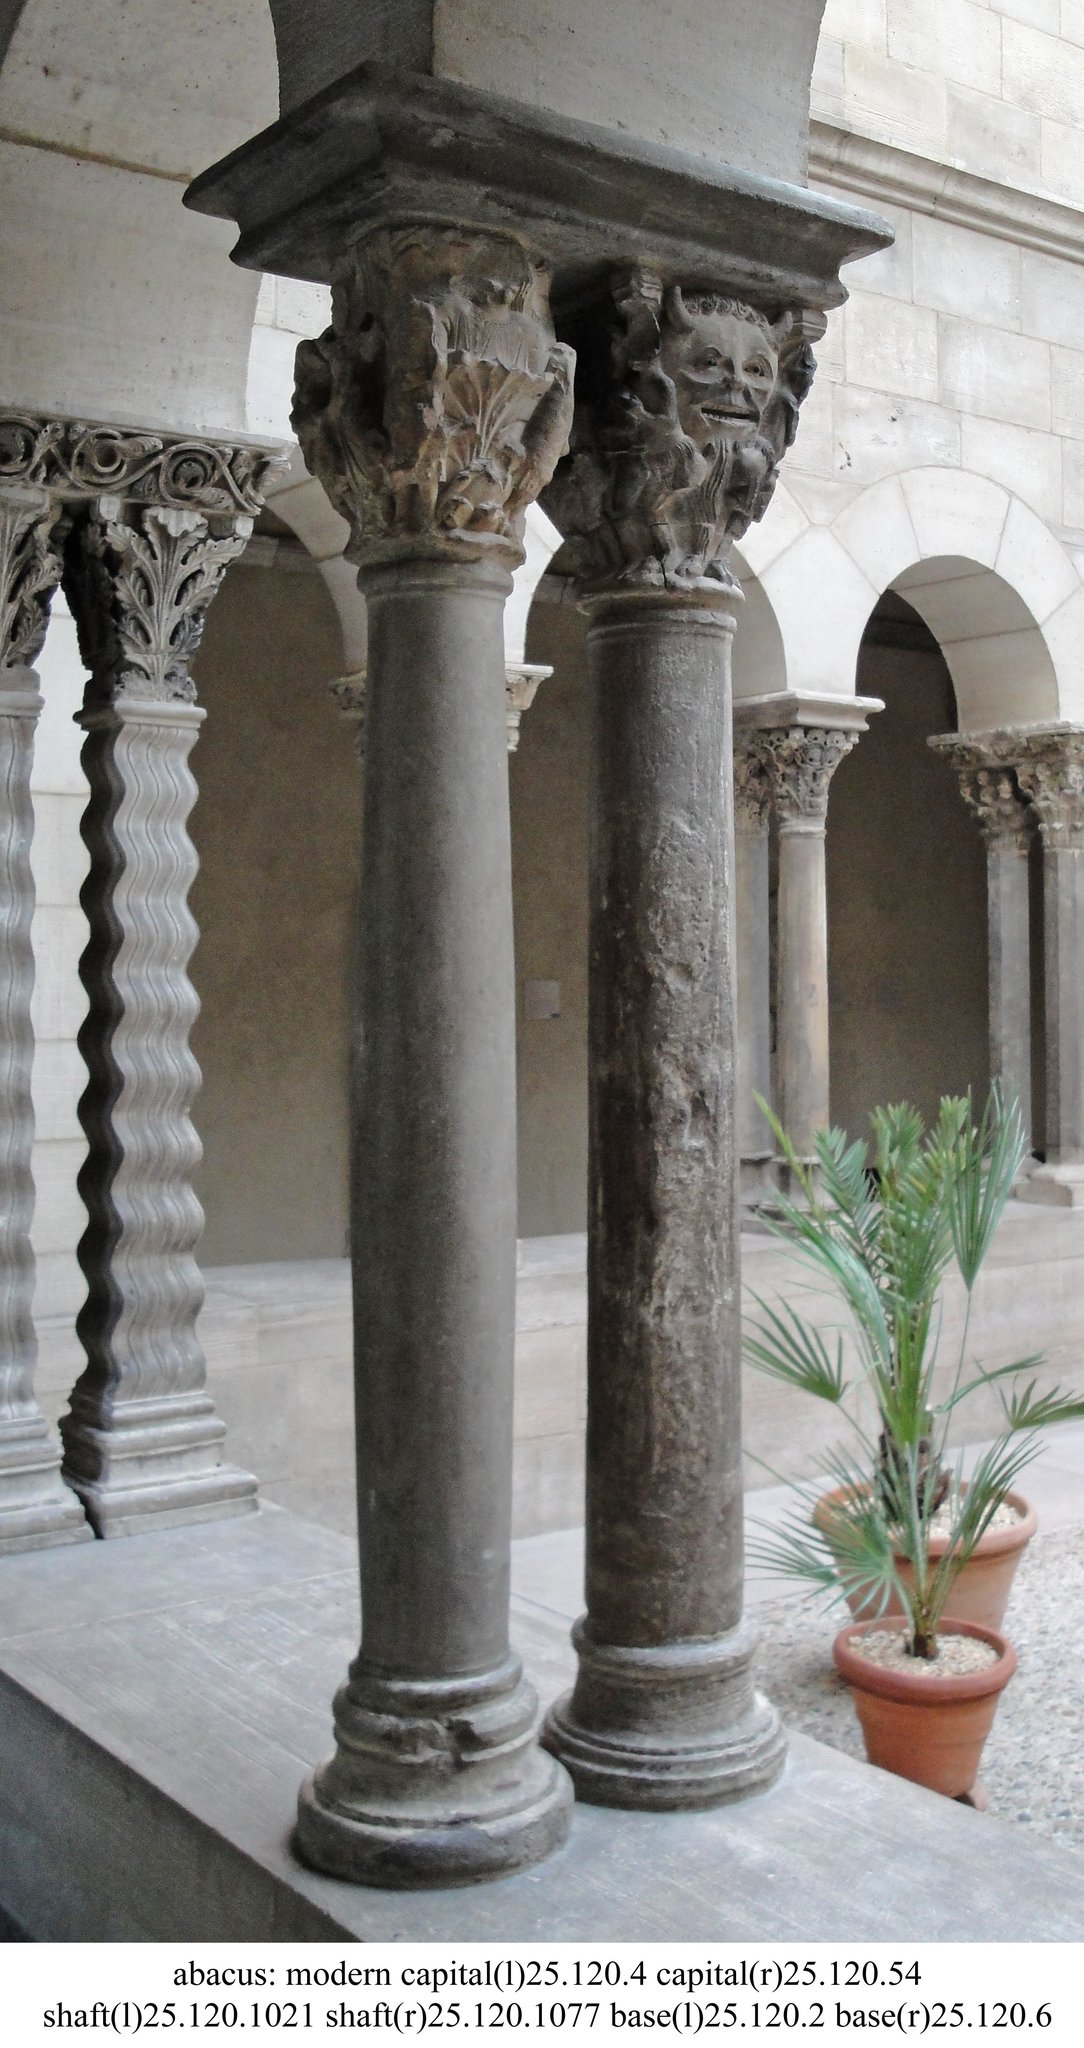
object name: capital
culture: french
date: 1167-1200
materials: limestone